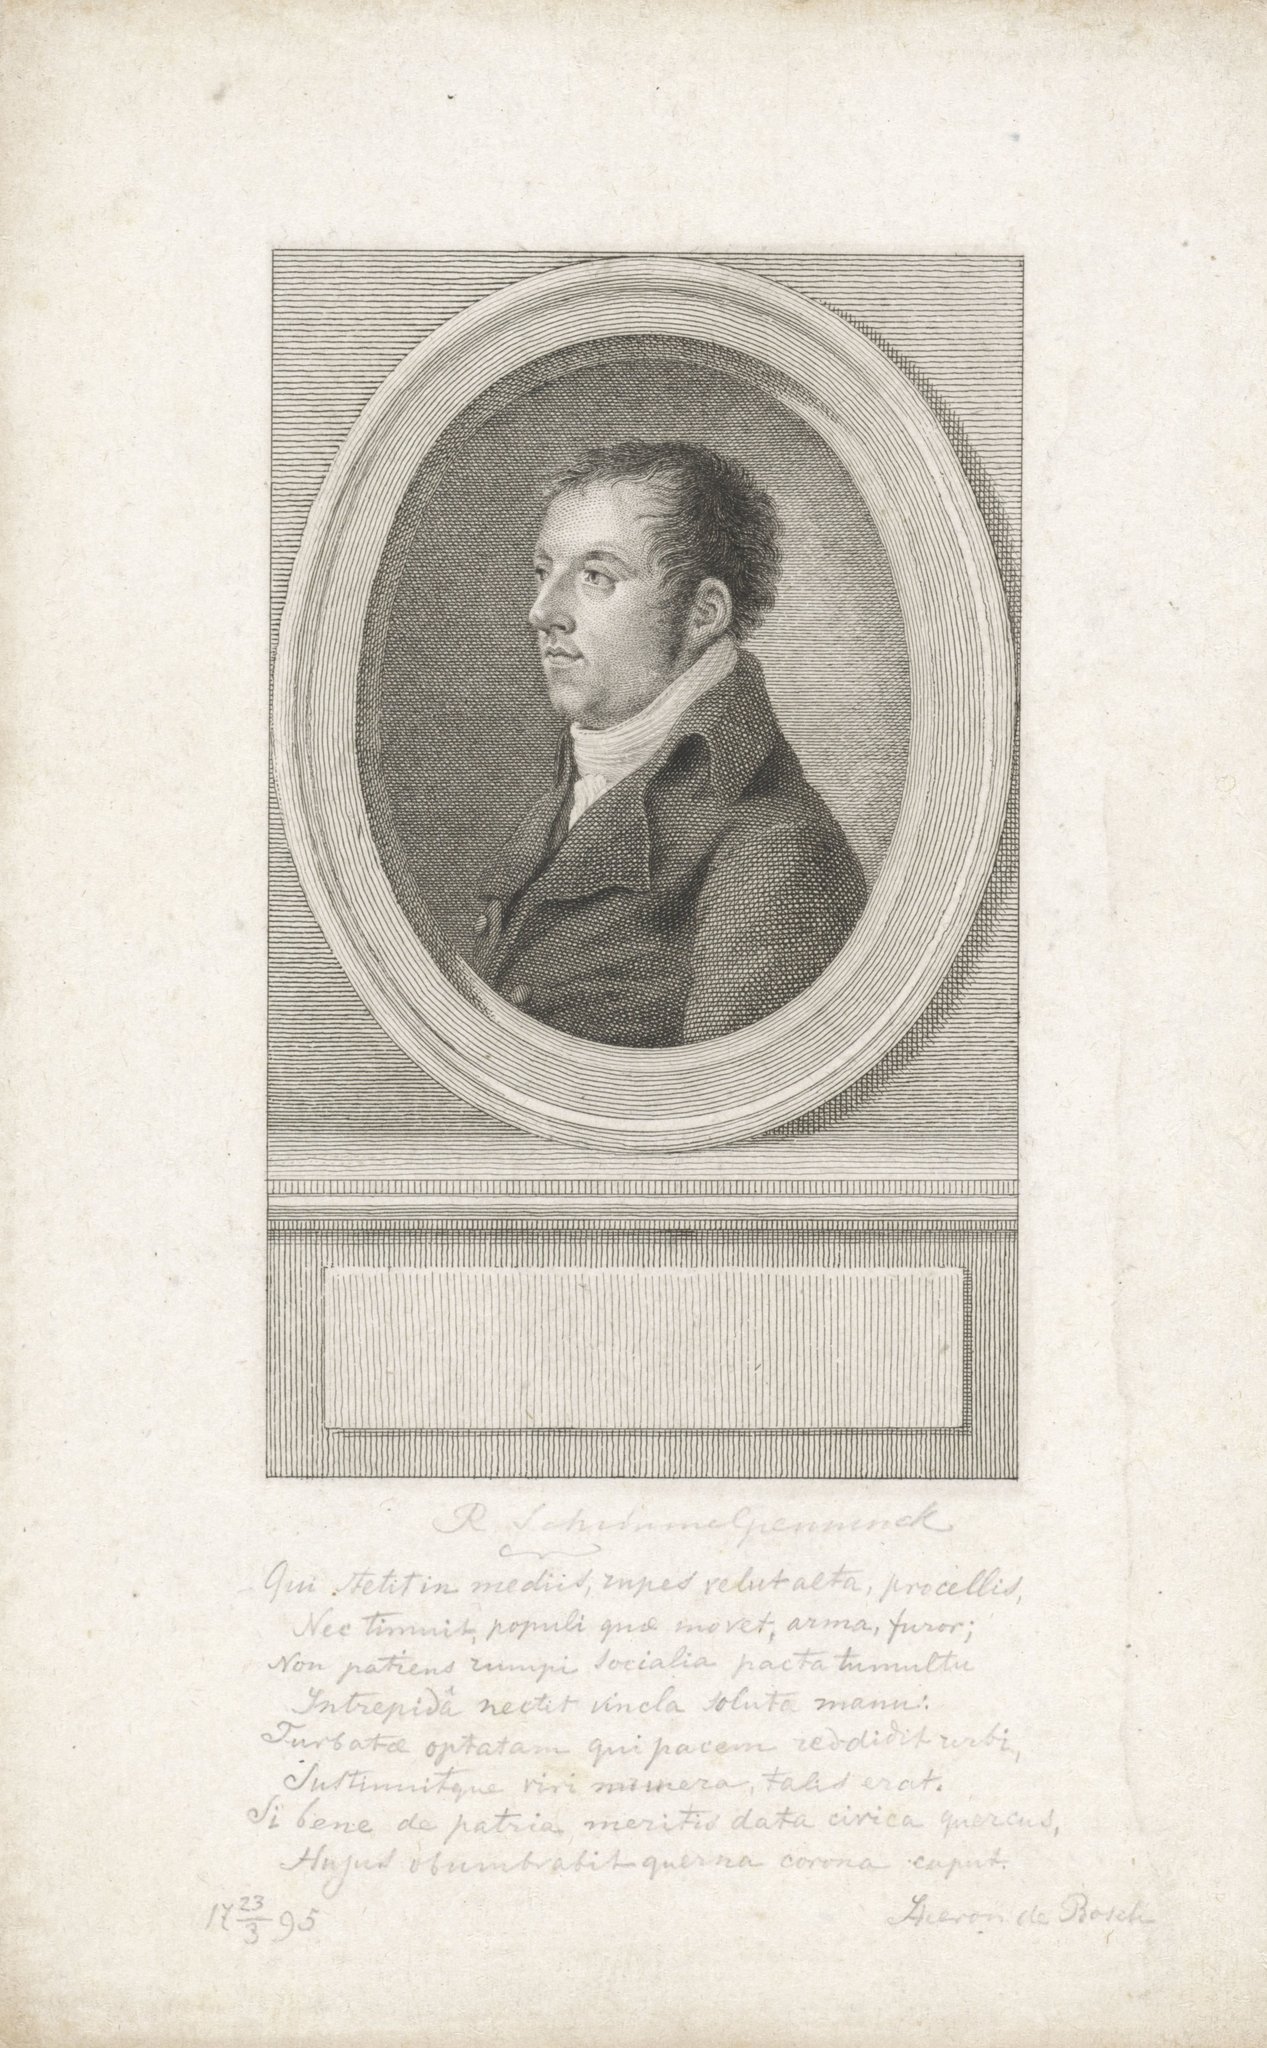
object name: print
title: Portret van Rutger Jan Schimmelpenninck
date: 1805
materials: paper, pencil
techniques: engraving, etching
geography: amsterdam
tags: rutger jan schimmelpenninck (1761-1825)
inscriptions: poem: ‘negenregelig gedicht in het Frans ondertekend door A[...]eron de Bosch’, collector's mark: Lugt 2228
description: Latere staat prent ook gebruikt als boekillustratie in: Wagenaar, Jan. Vaderlandsche historie, (...) ten vervolge van Wagenaars Vaderlandsche historie. 43 dln. Amsterdam: Johannes Allart, 1805, dl. 35.